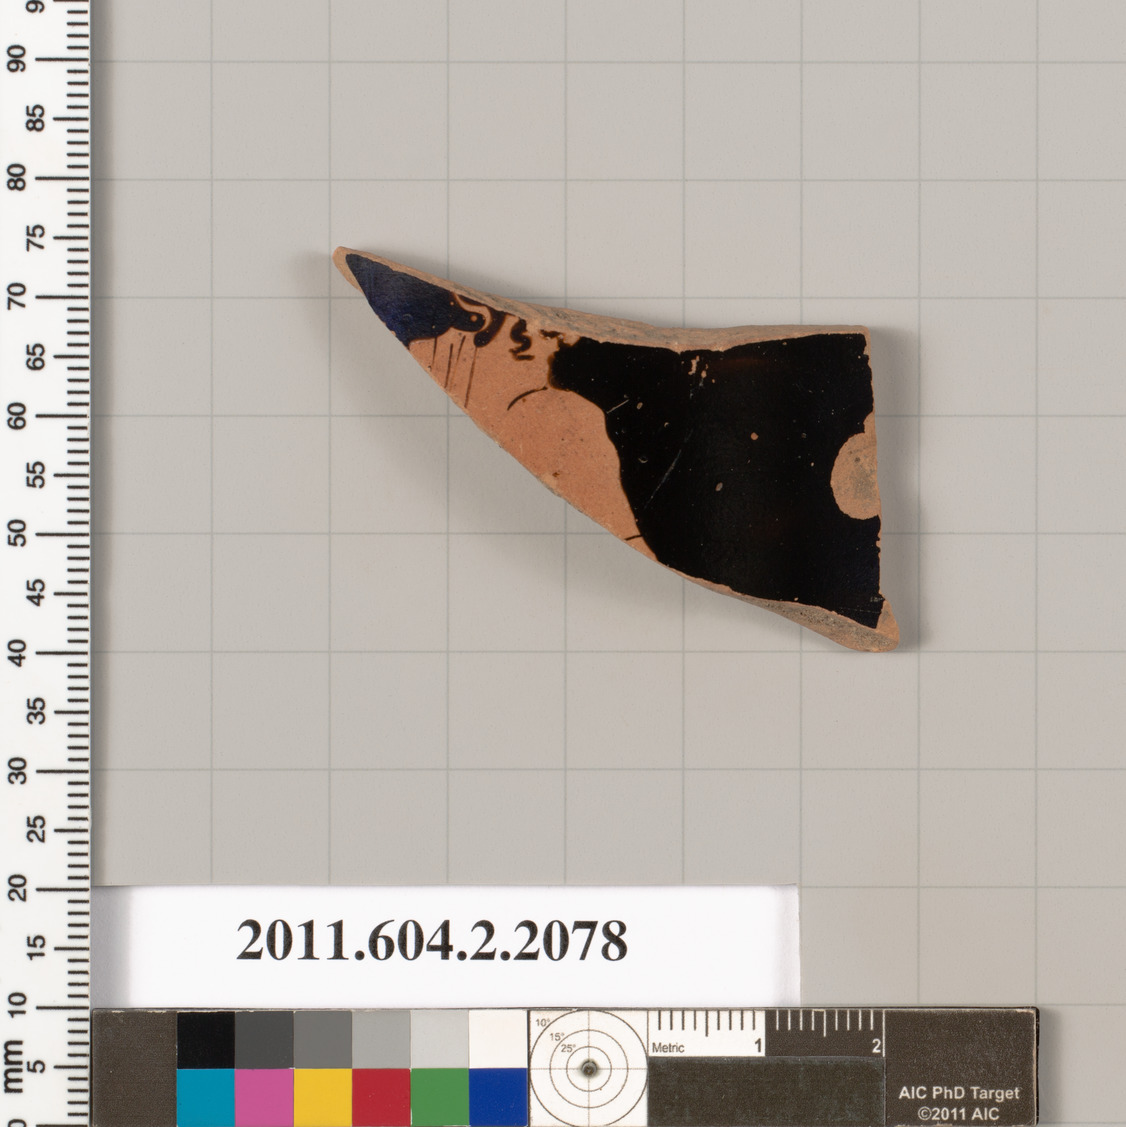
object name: mug fragment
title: Terracotta fragment of a mug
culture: greek, attic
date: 460-440 BCE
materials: terracotta